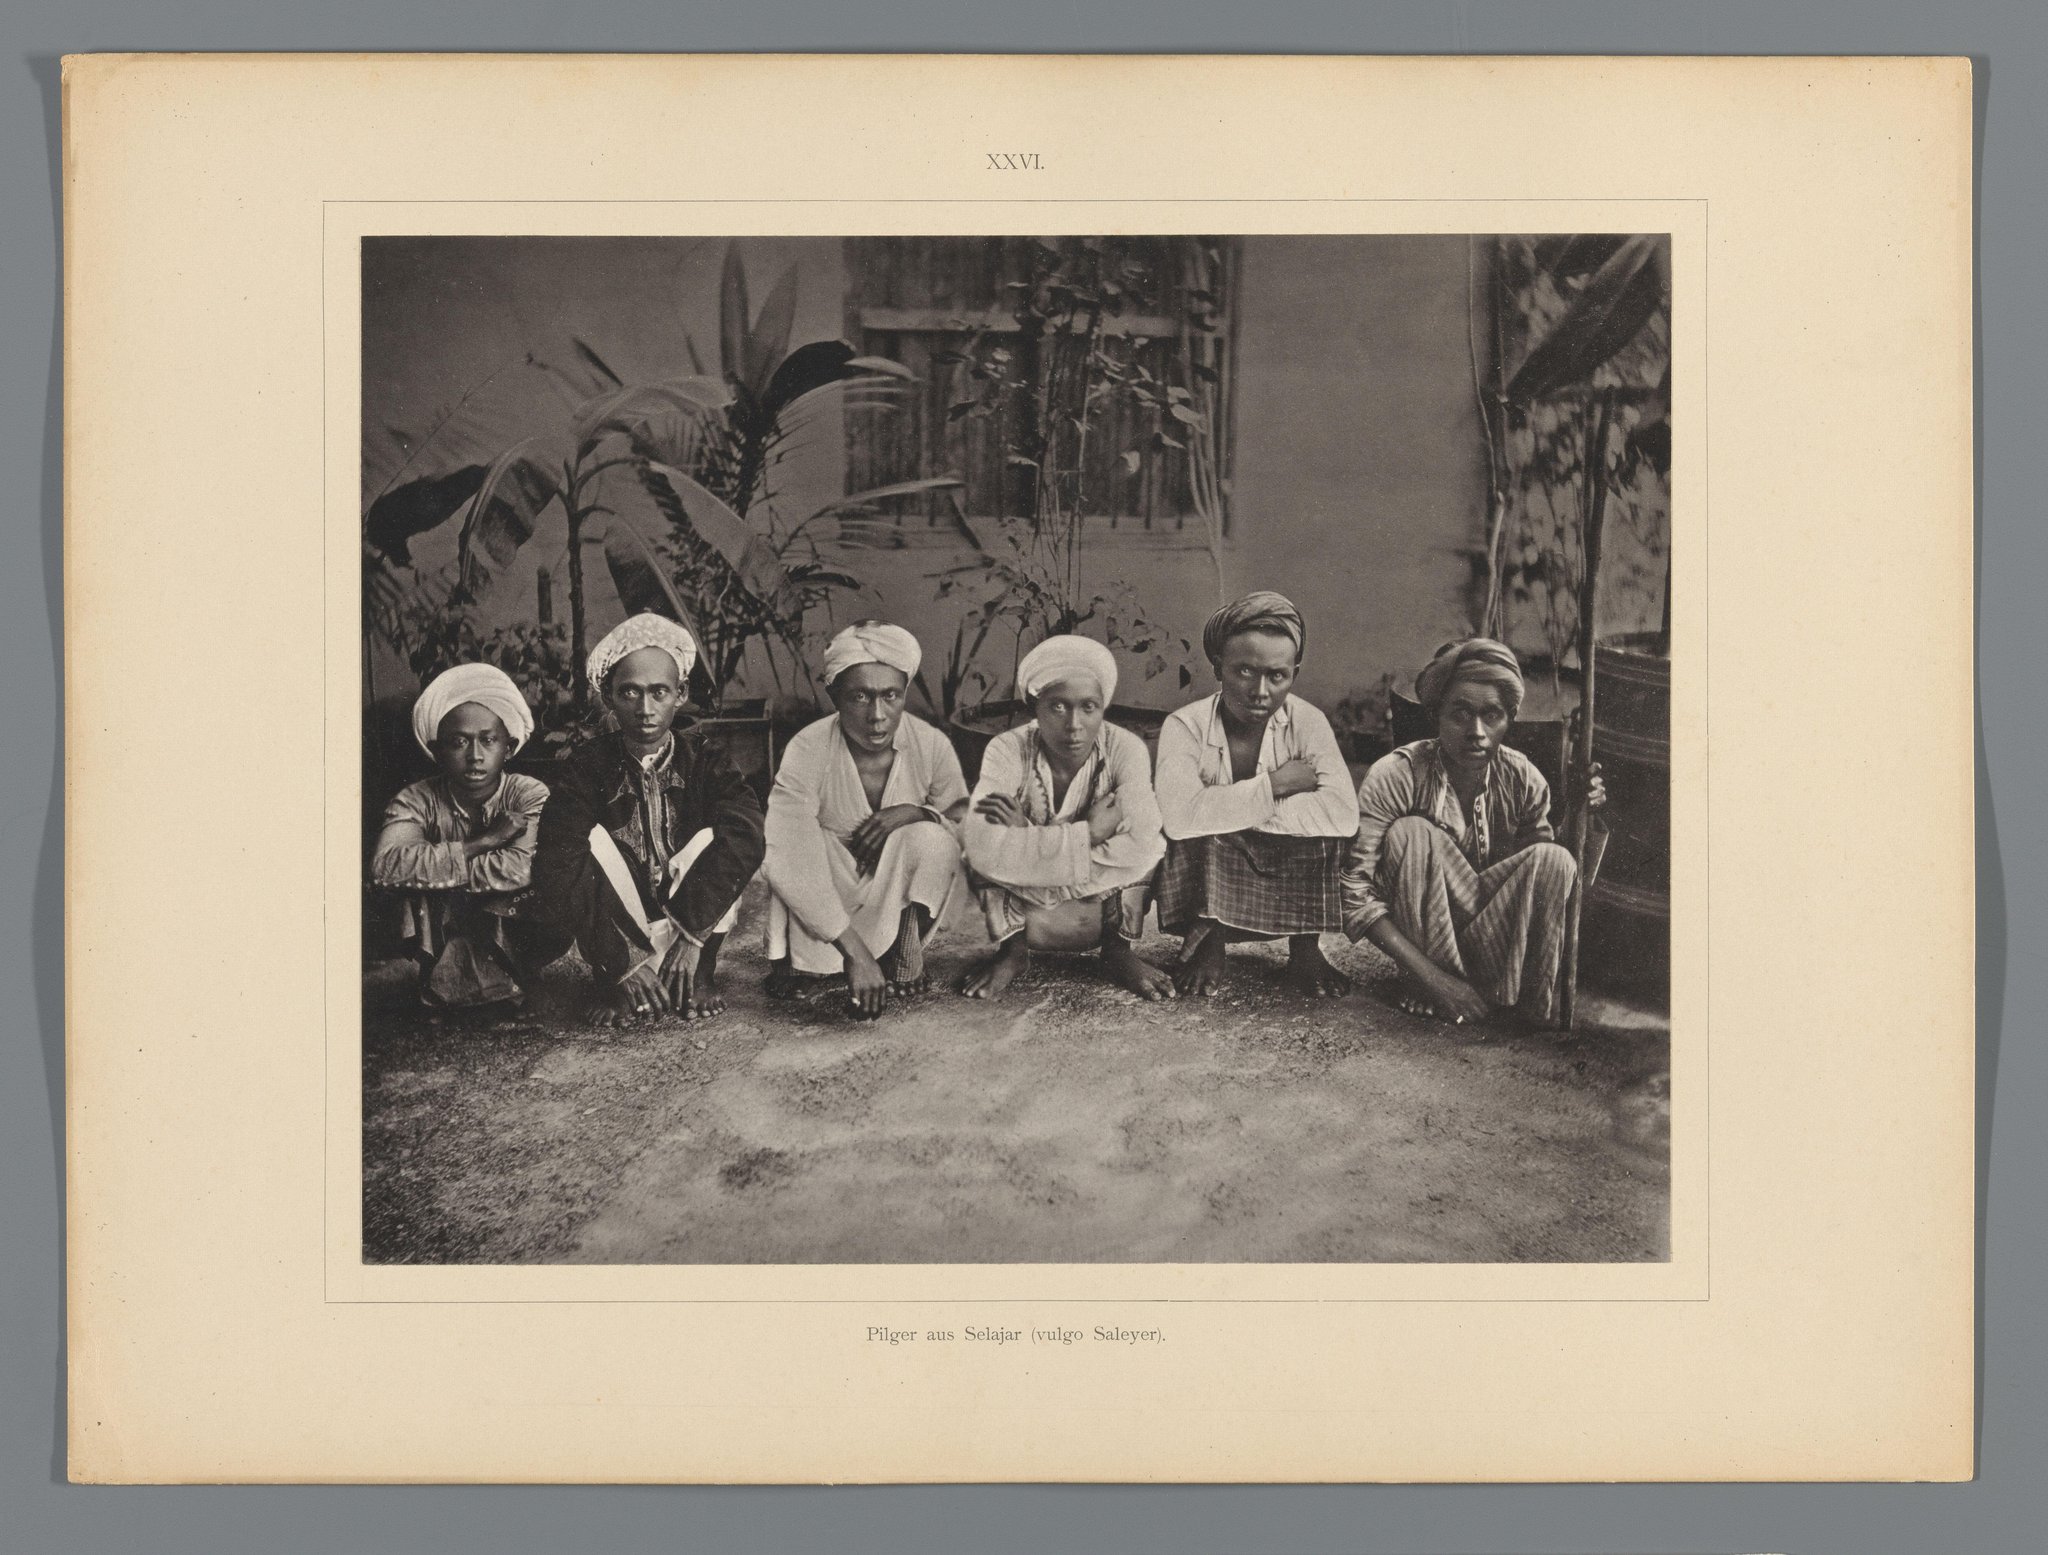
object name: photomechanical print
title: Pilger aus Selejar (vulgo Saleyer)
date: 1884-1888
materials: paper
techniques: photograph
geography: djedda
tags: the believer ~ islam, mohammedanism, historical persons (portraits and scenes from the life) - bb - woman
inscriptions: number: ‘XXVI.’